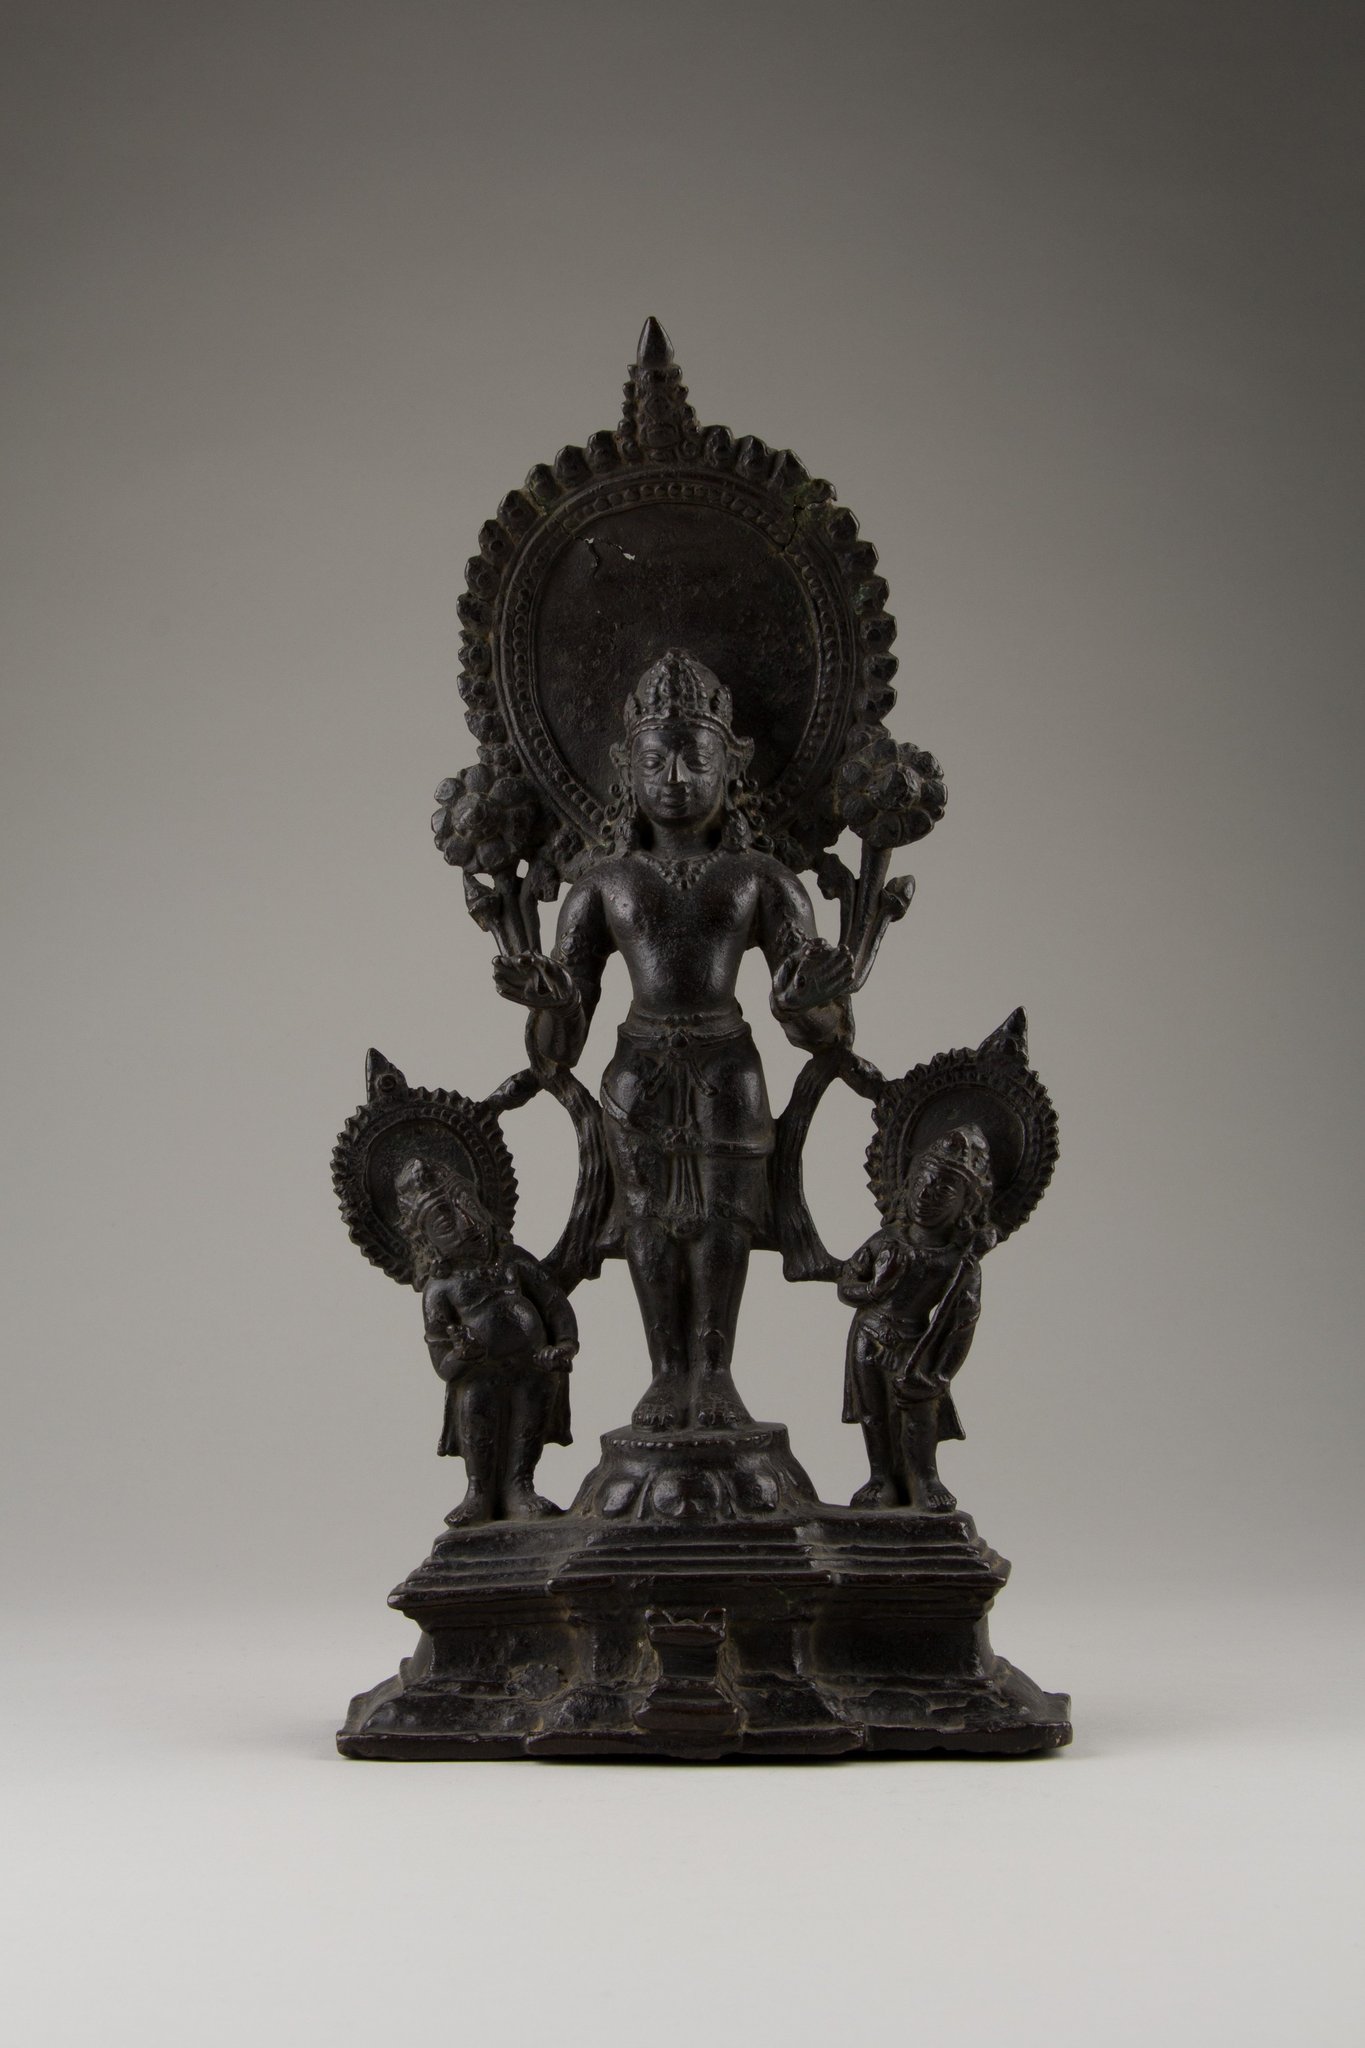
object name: group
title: Surya, the Sun God, with Attendants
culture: bangladeshi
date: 801-900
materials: bronze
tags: men